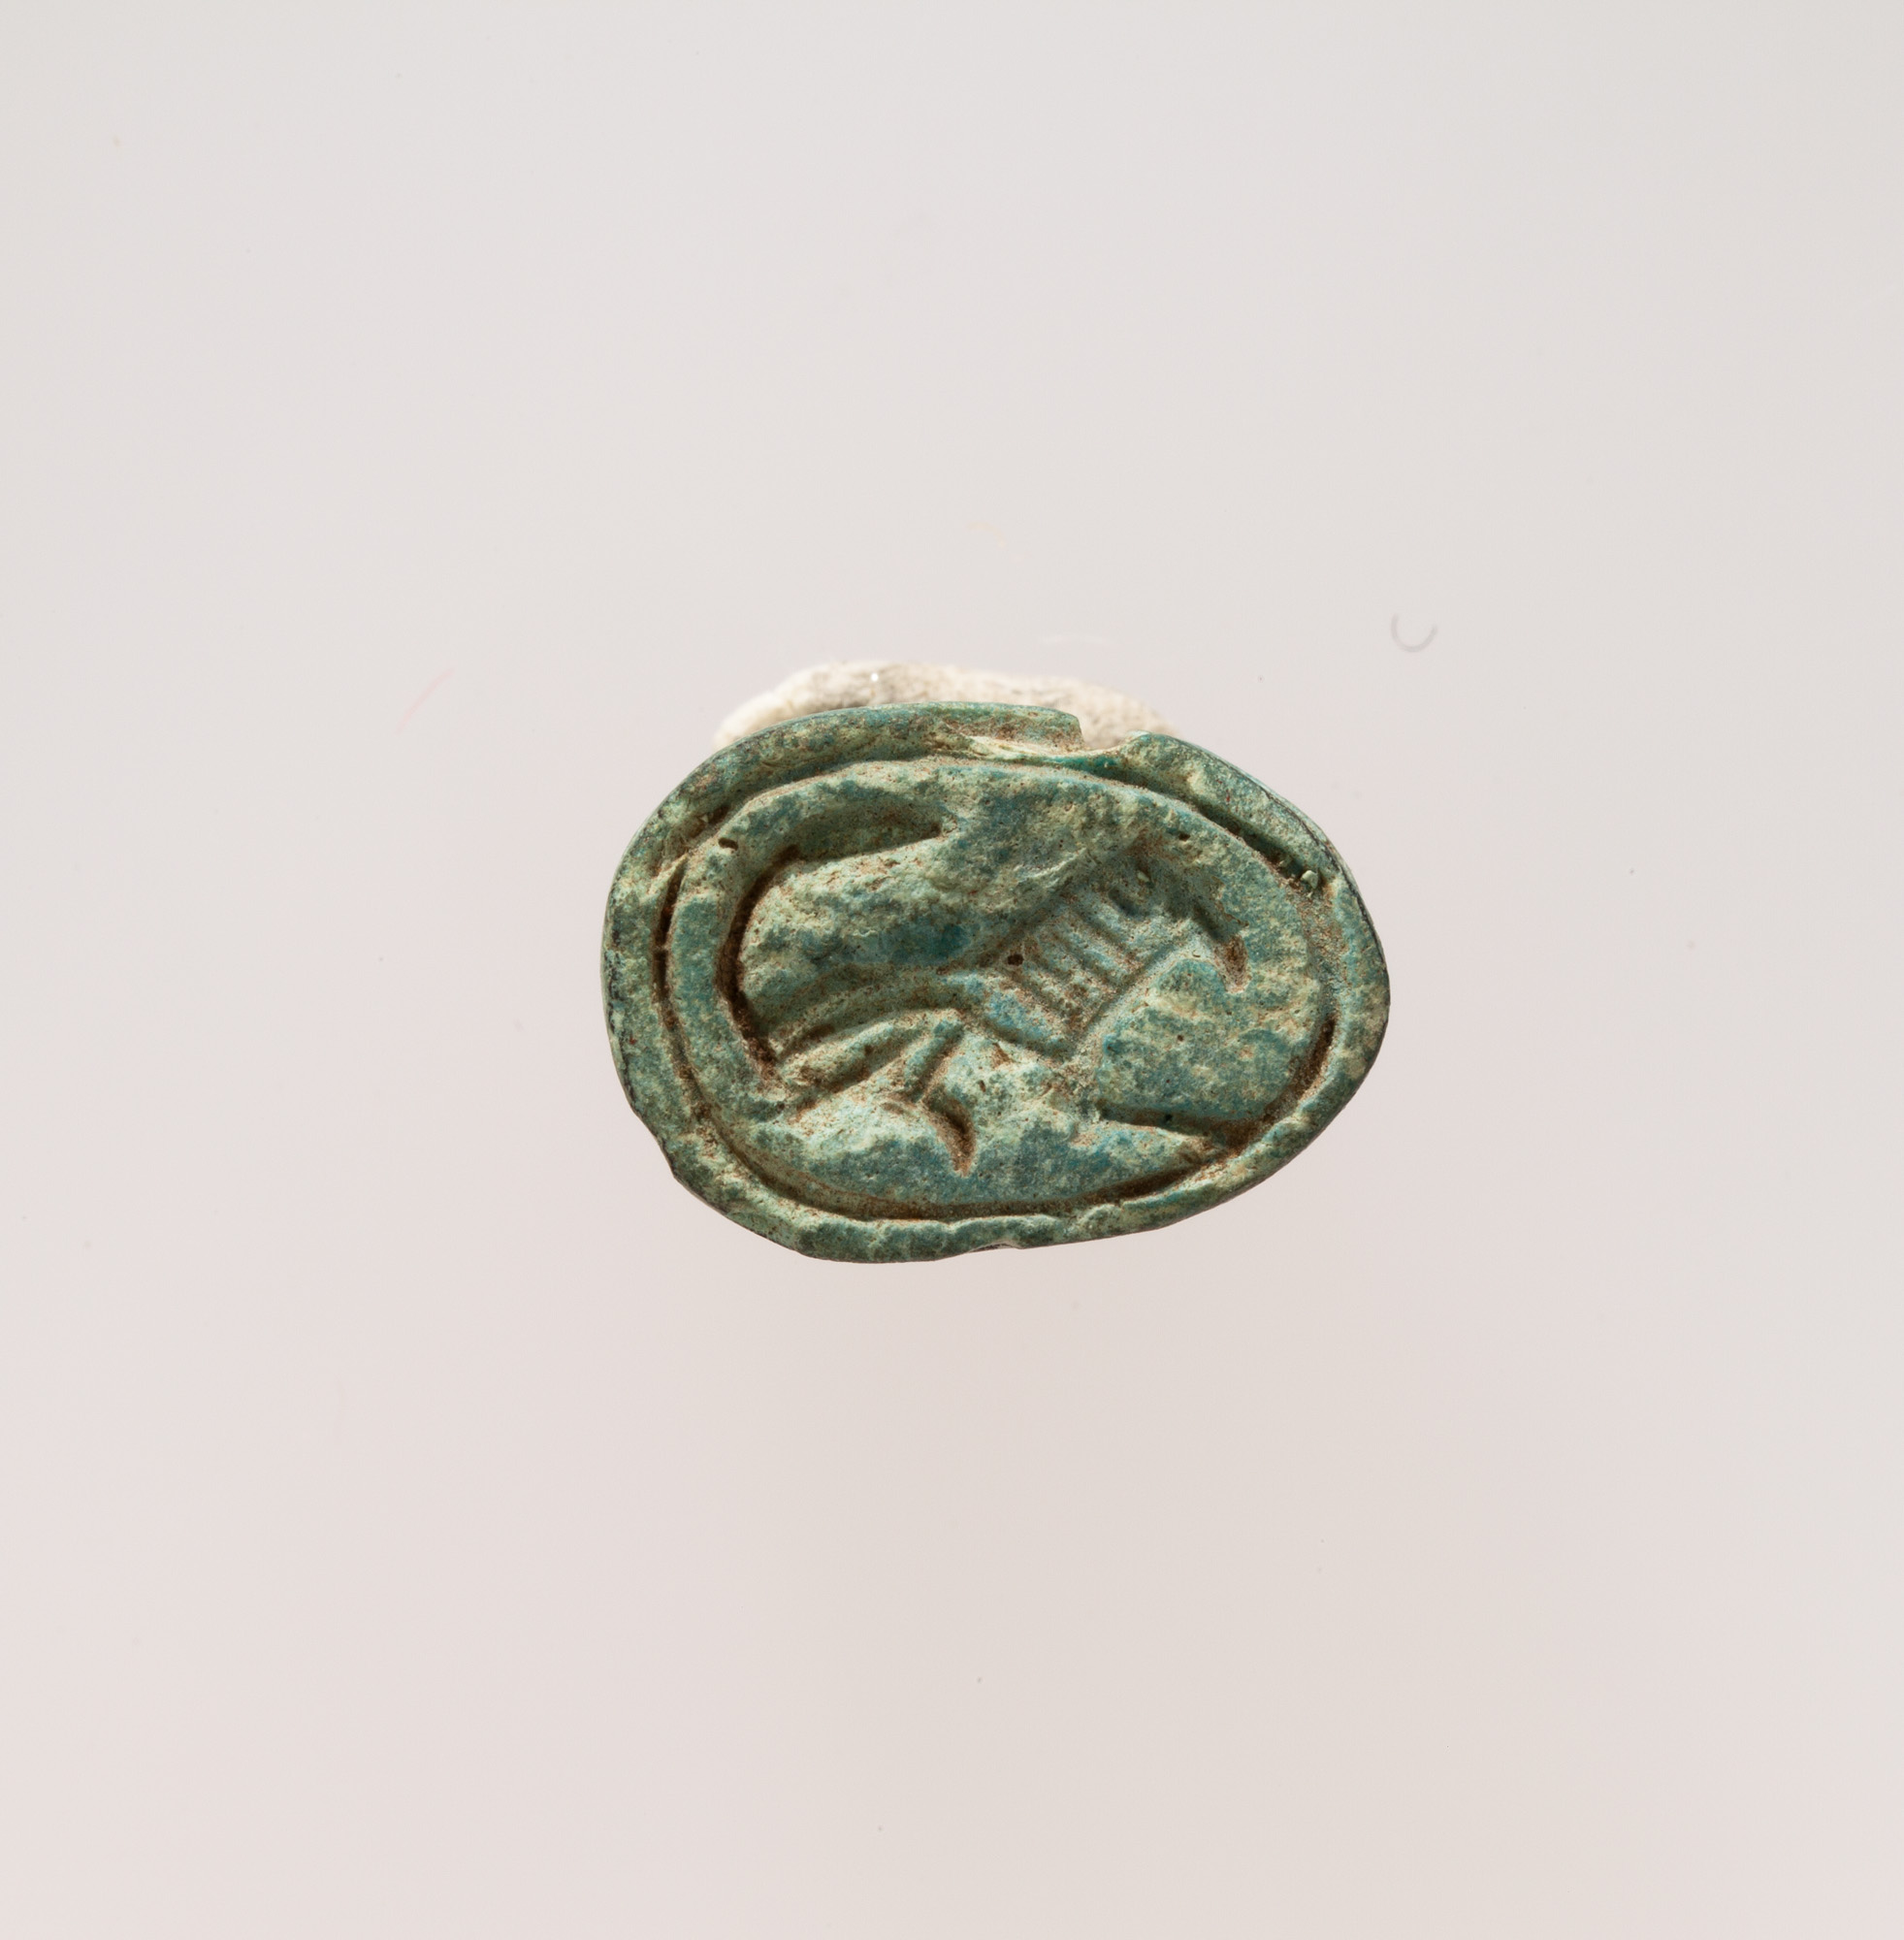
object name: scarab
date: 1479-1458 BCE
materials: faience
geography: egypt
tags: scarabs